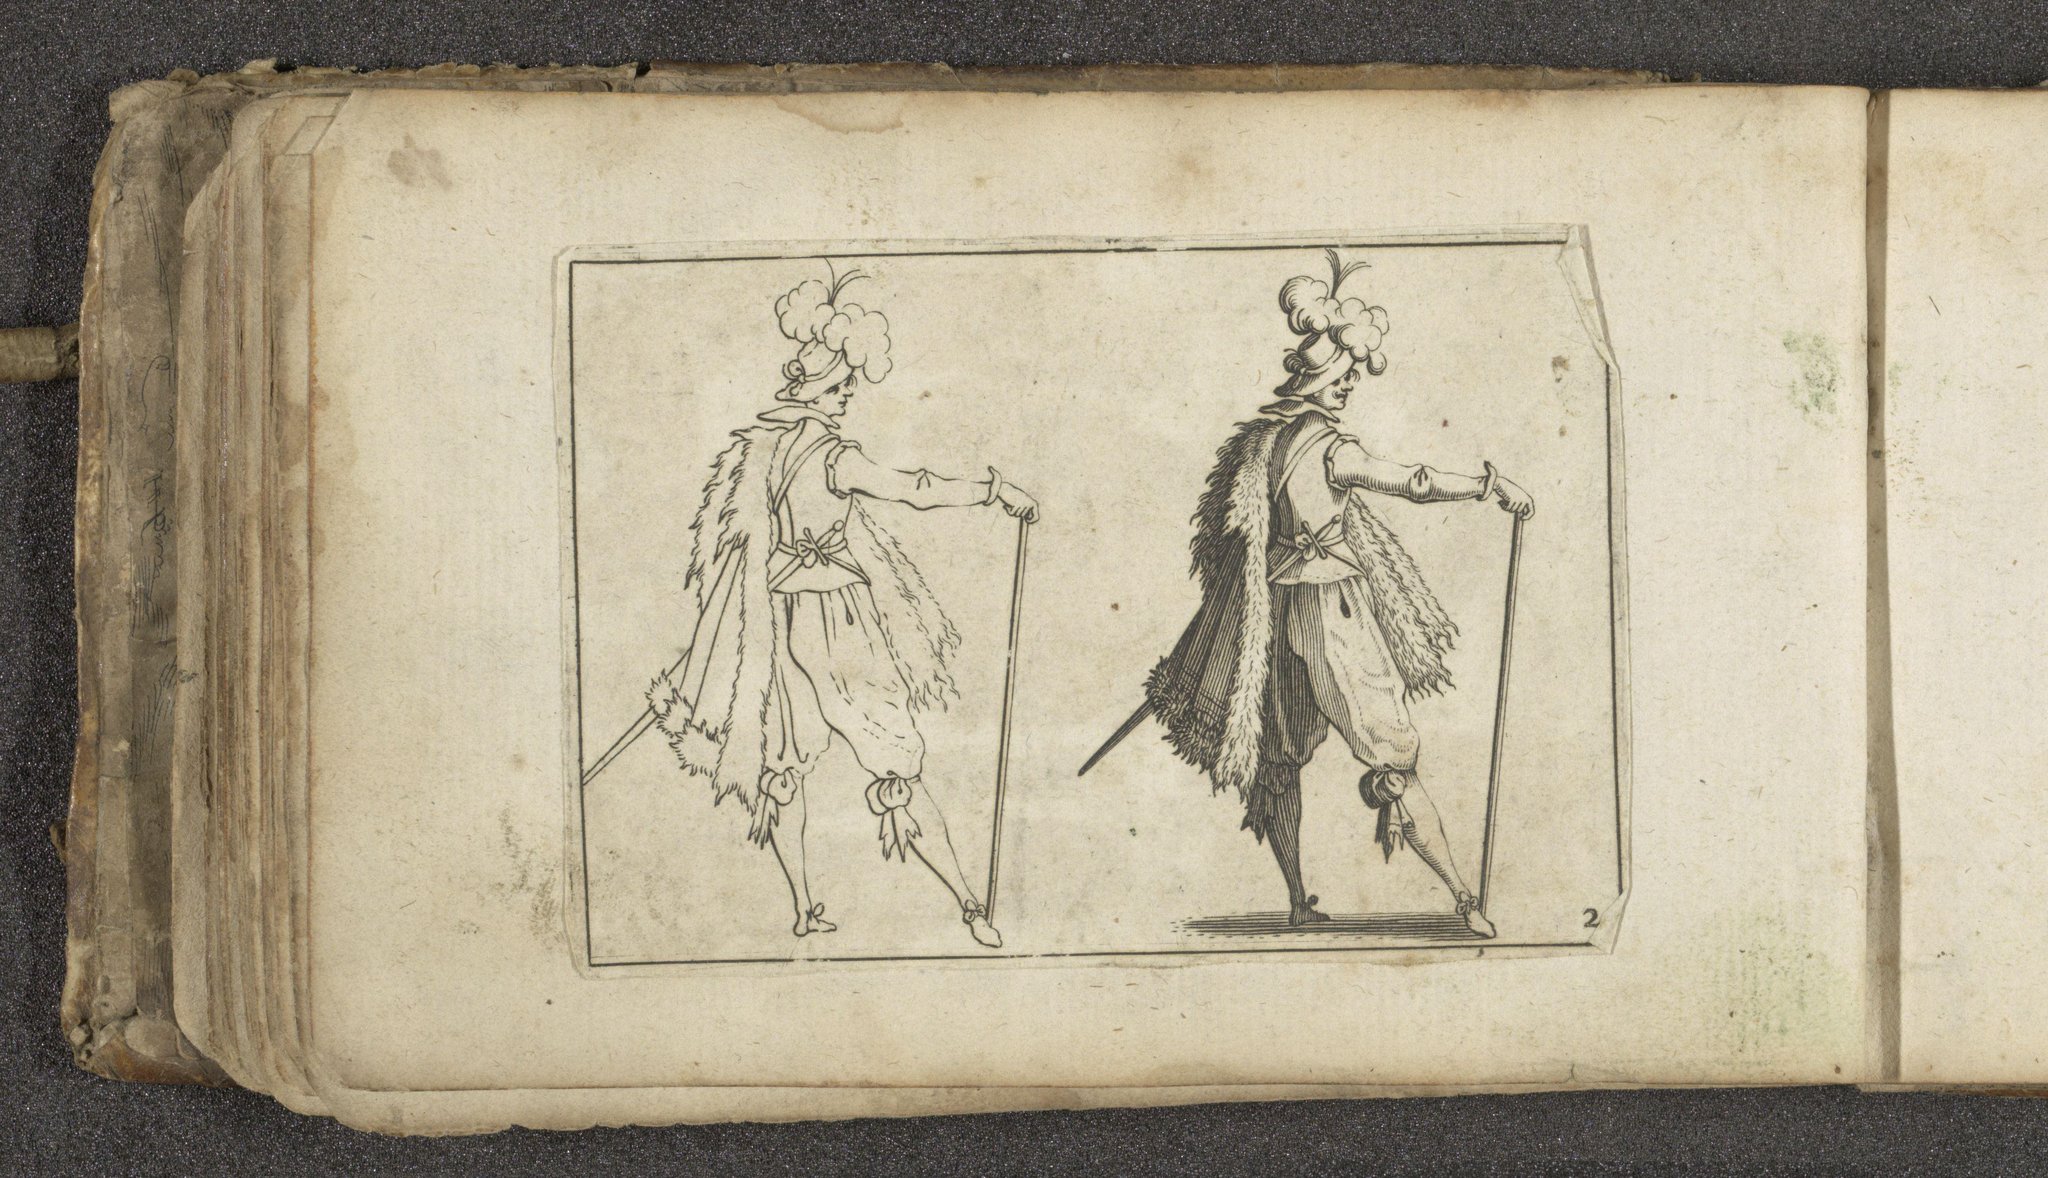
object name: print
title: Acteur met gepluimde hoed, in tweevoud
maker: paul göttich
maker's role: graveur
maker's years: 1586-1622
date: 1621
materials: paper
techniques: engraving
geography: augsburg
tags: actor (on the stage), head-gear: hat (+ feathers used for clothes)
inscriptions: inscription: ‘50’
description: Staande heer of acteur met gepluimde hoed, lange mantel en wandelstok, in tweevoud. De prent maakt deel uit van een album.